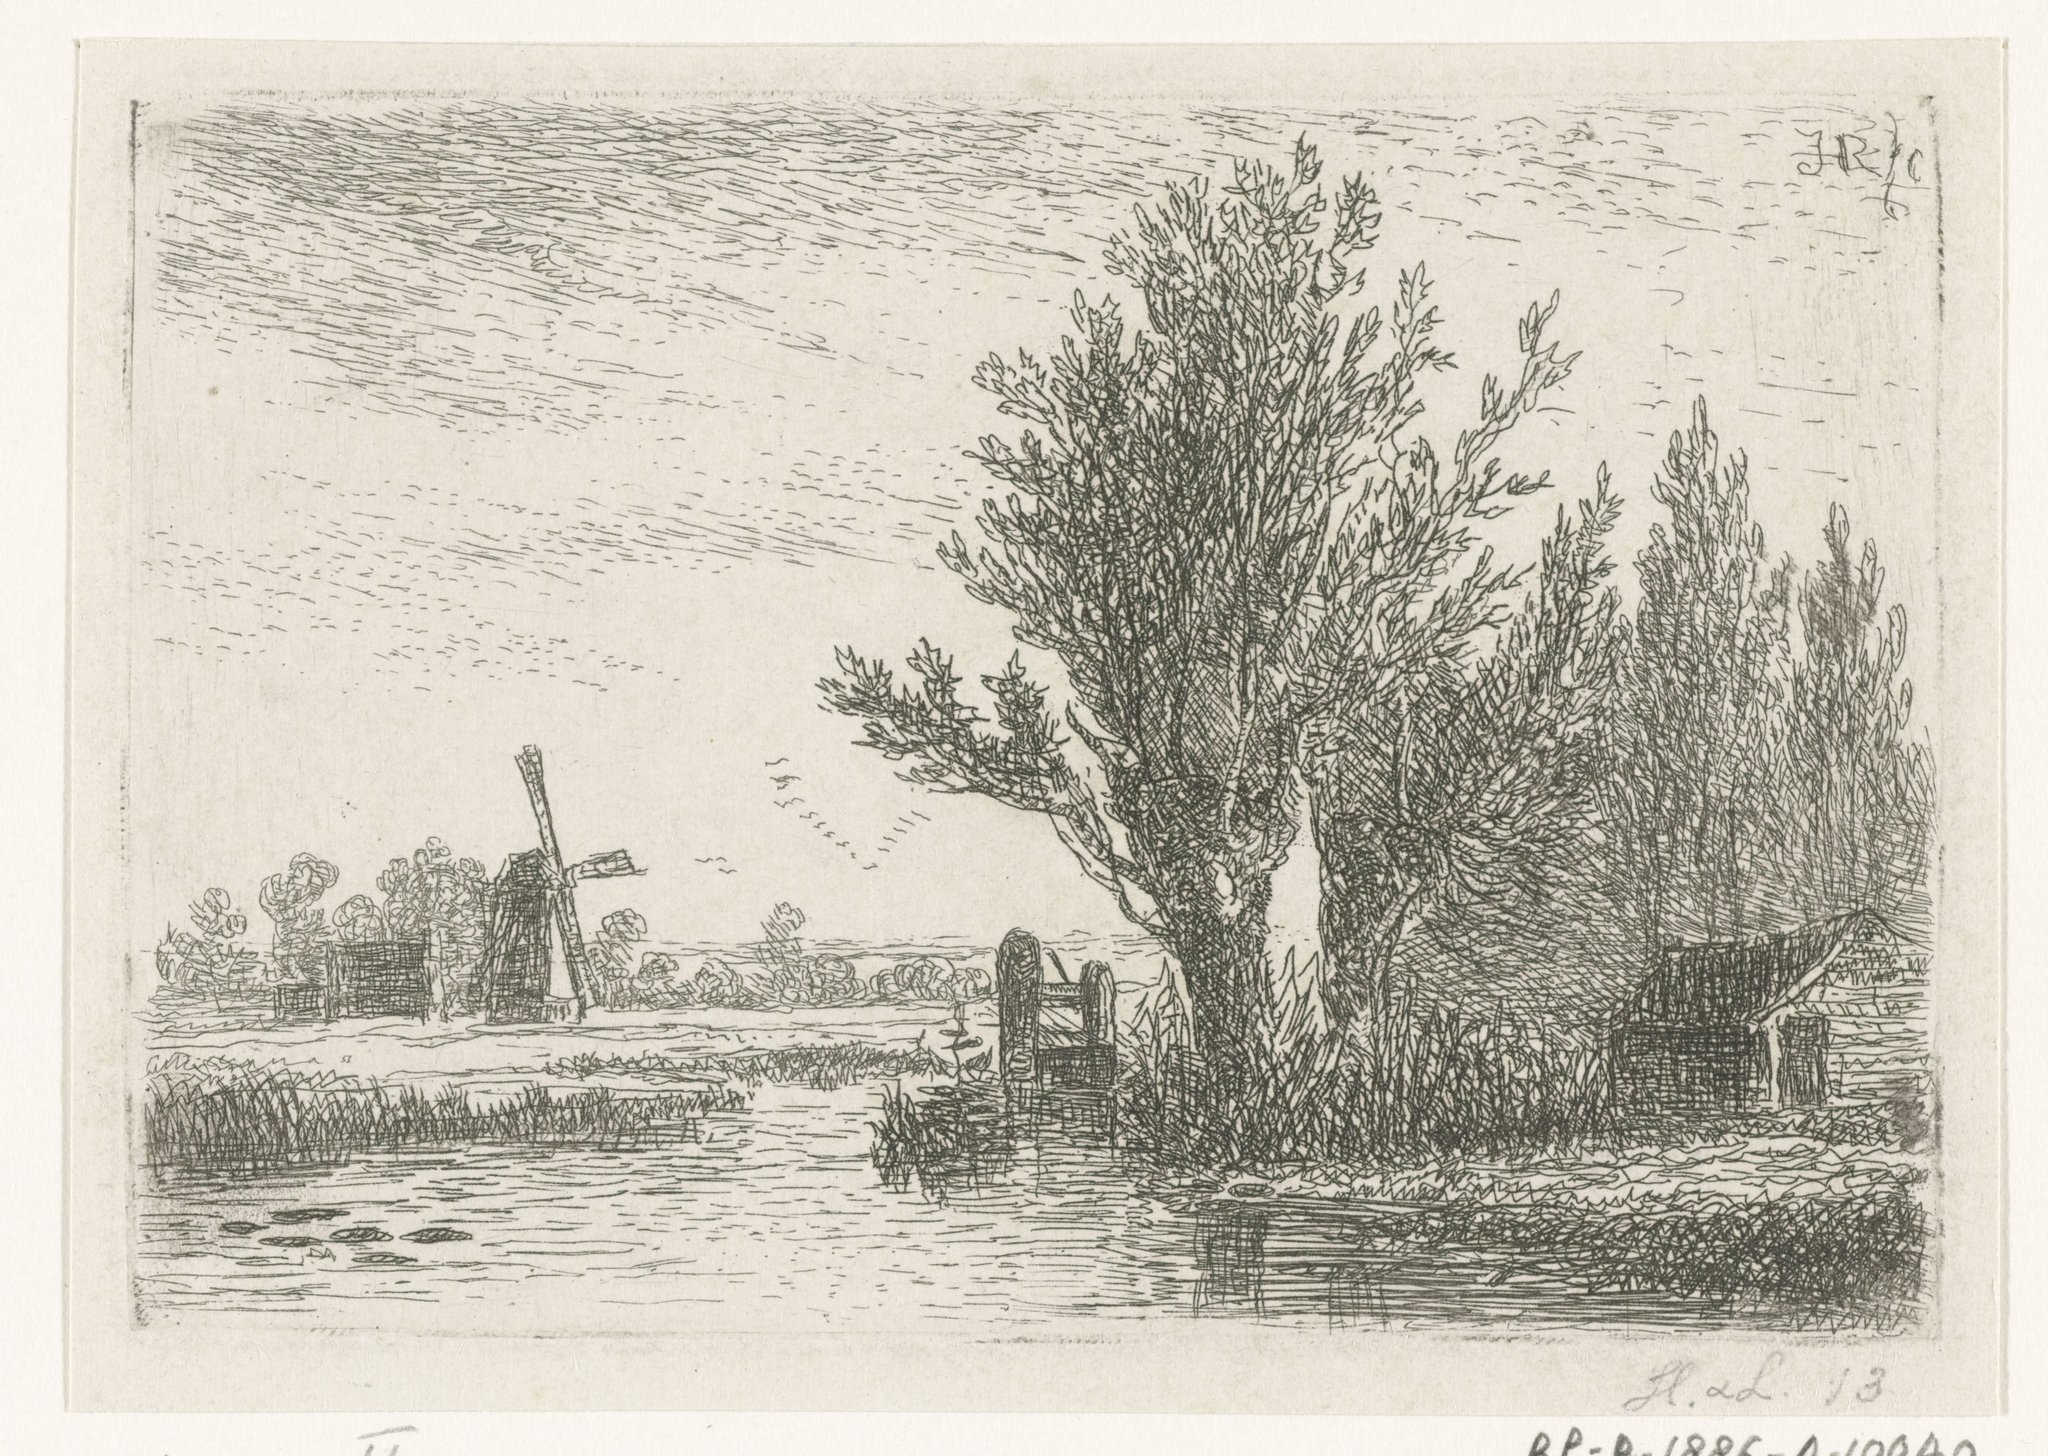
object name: print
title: Sluis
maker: hermanus jan hendrik van rijkelijkhuysen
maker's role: painter, print maker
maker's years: 1813-1883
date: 1823-1883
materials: paper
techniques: etching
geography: utrecht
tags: sluice, weir, river, trees: willow, windmill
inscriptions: collector's mark: Lugt 2228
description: Gezicht op een rivierlandschap met op de voorgrond een sluisje en twee knotwilgen. Op de achtergrond de contouren van een molen.